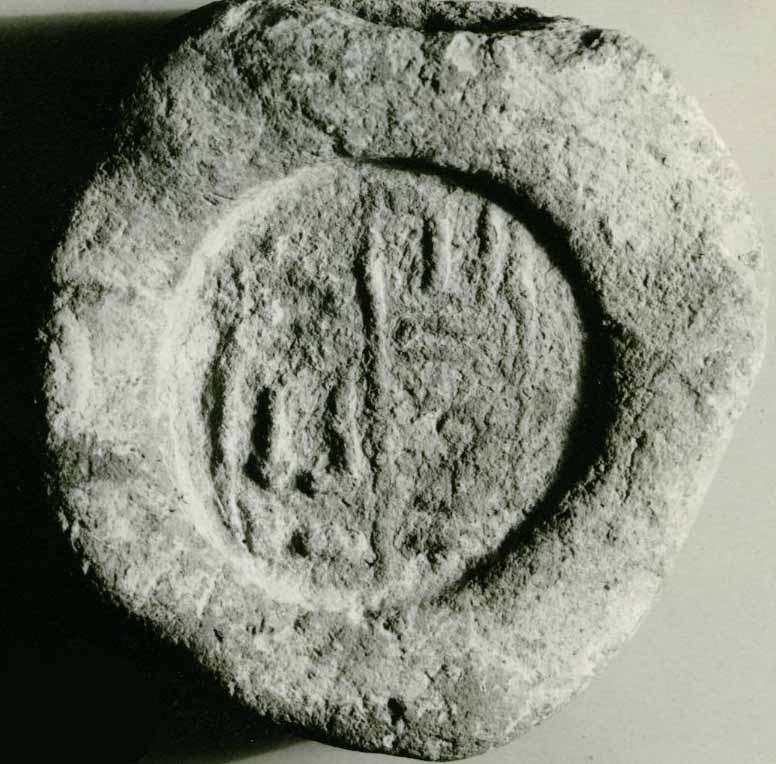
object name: cone, suemniut, royal cup bearer, circular impression,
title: Funerary Cone of the Royal Cup-Bearer Senemnetjer (?)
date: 1550-1295 BCE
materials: pottery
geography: egypt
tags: hieroglyphs